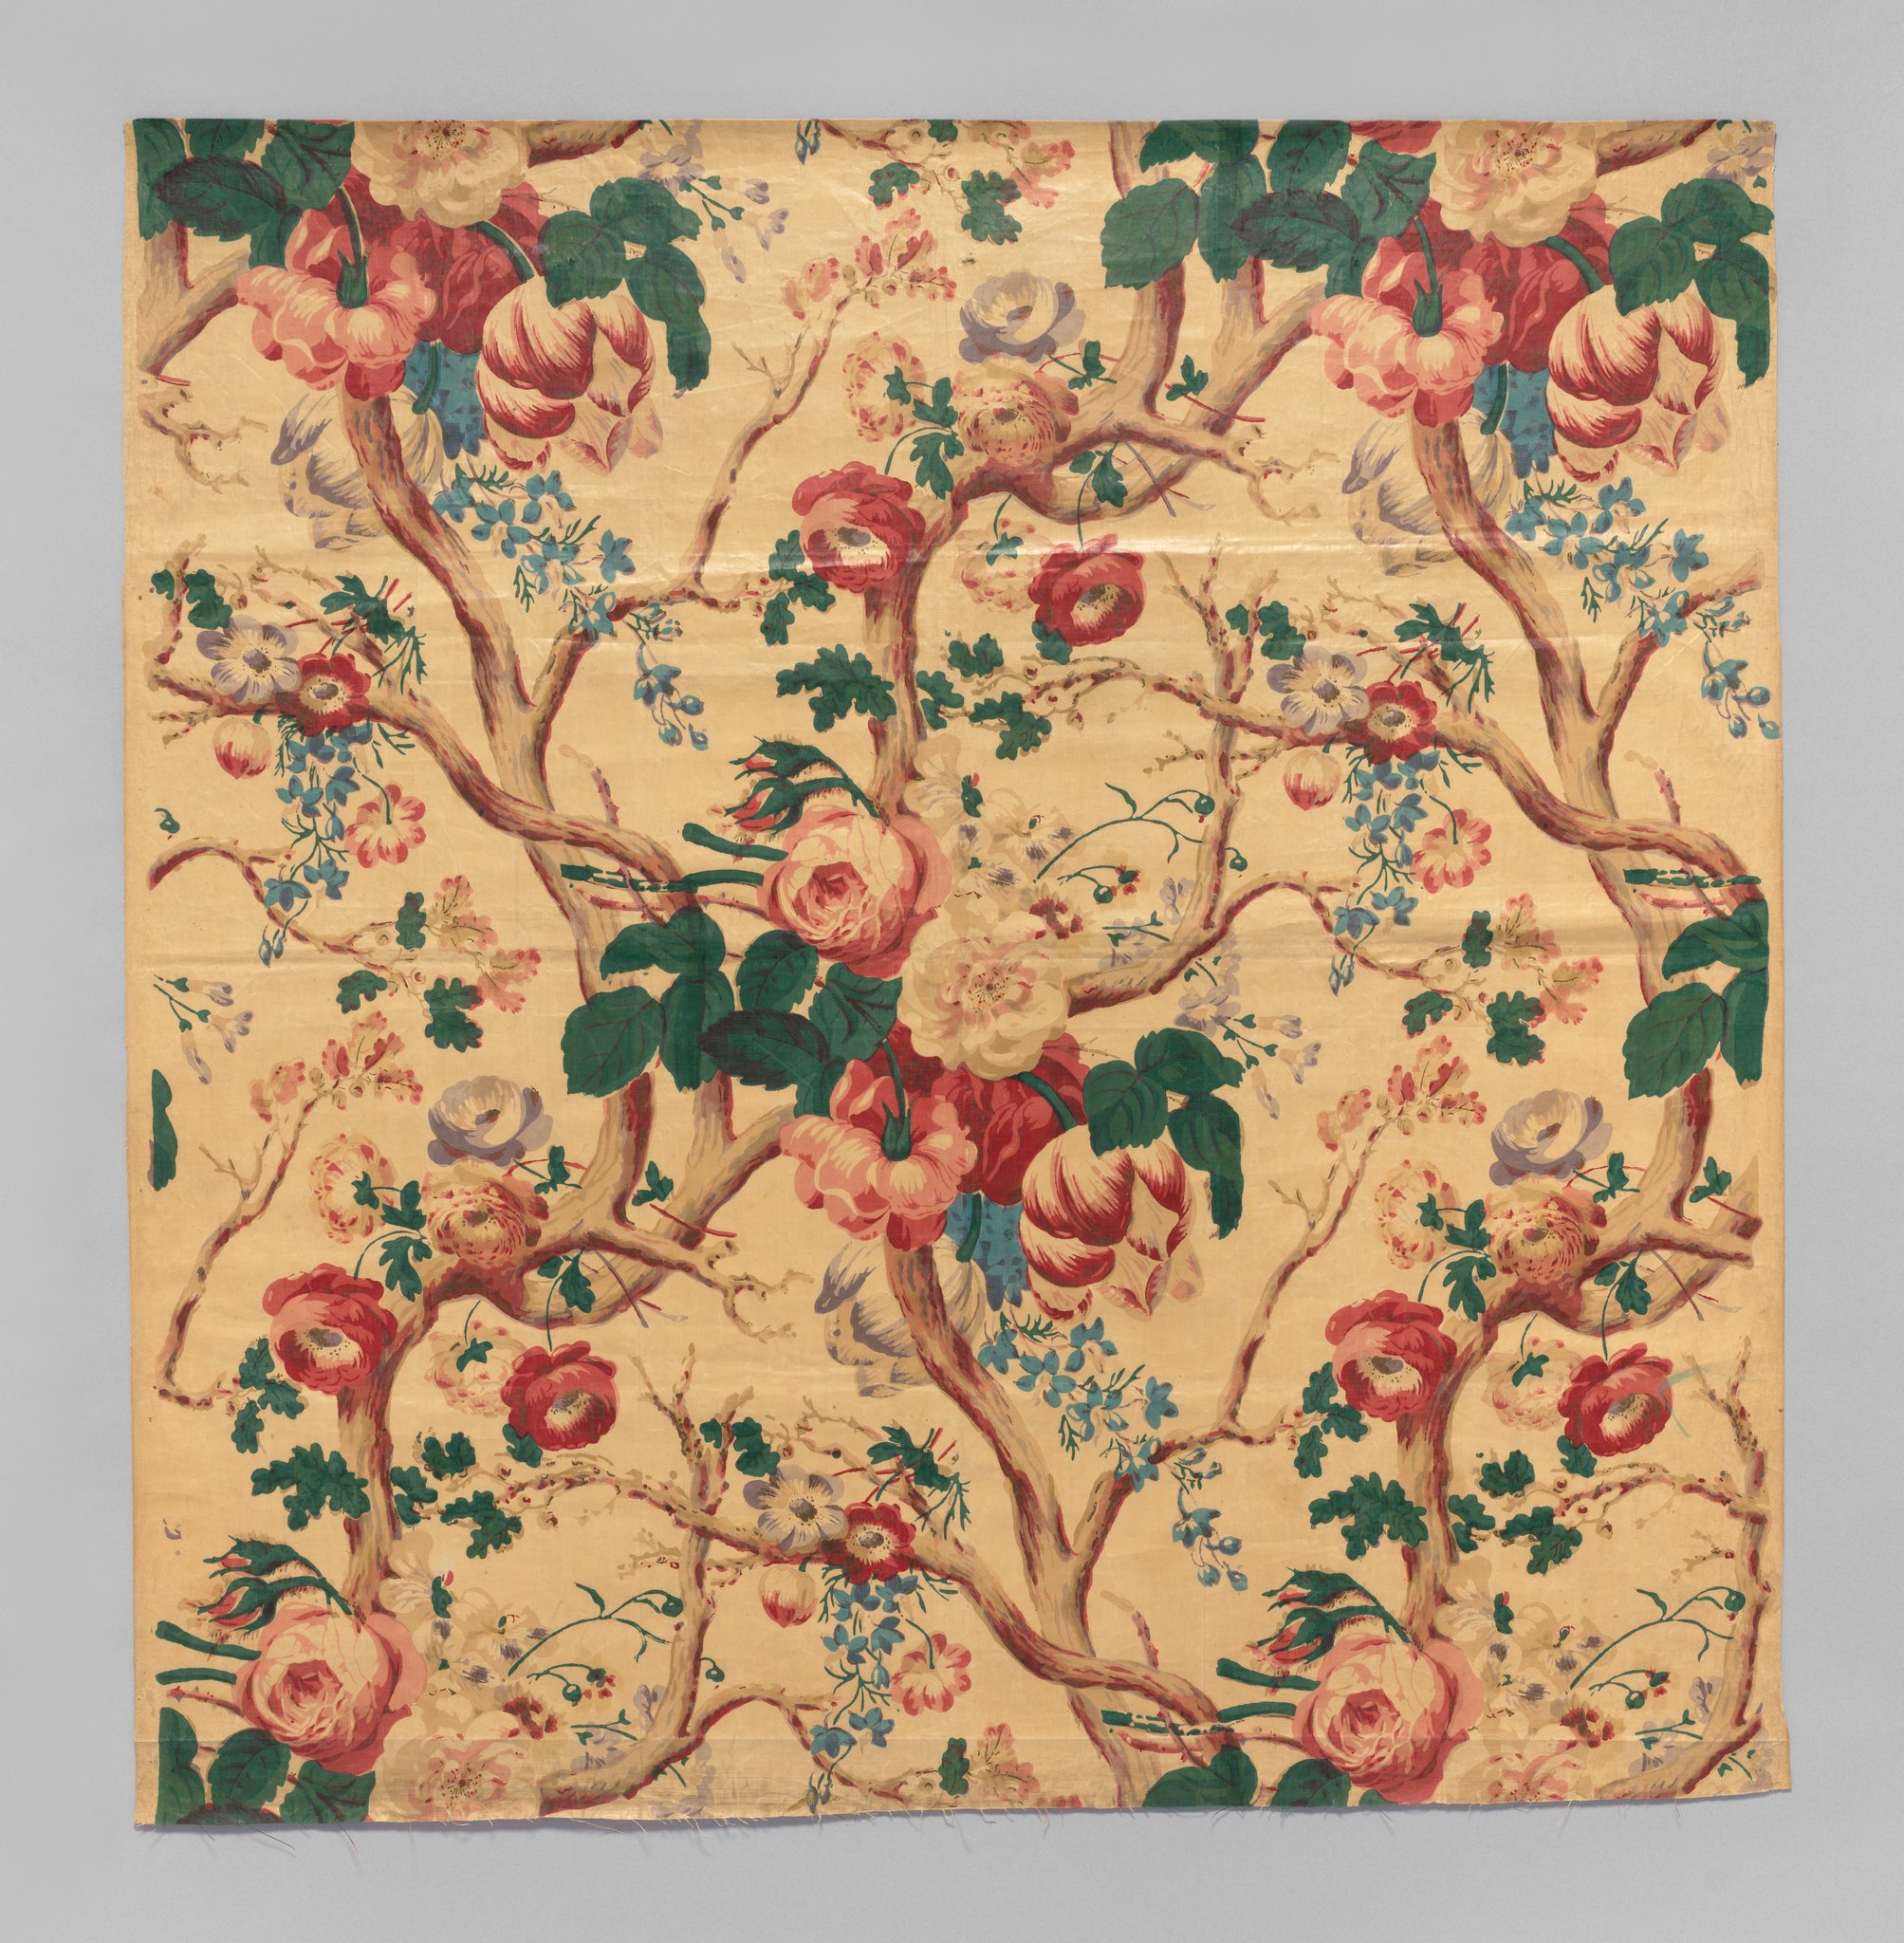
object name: piece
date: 1851-1872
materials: cotton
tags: flowers